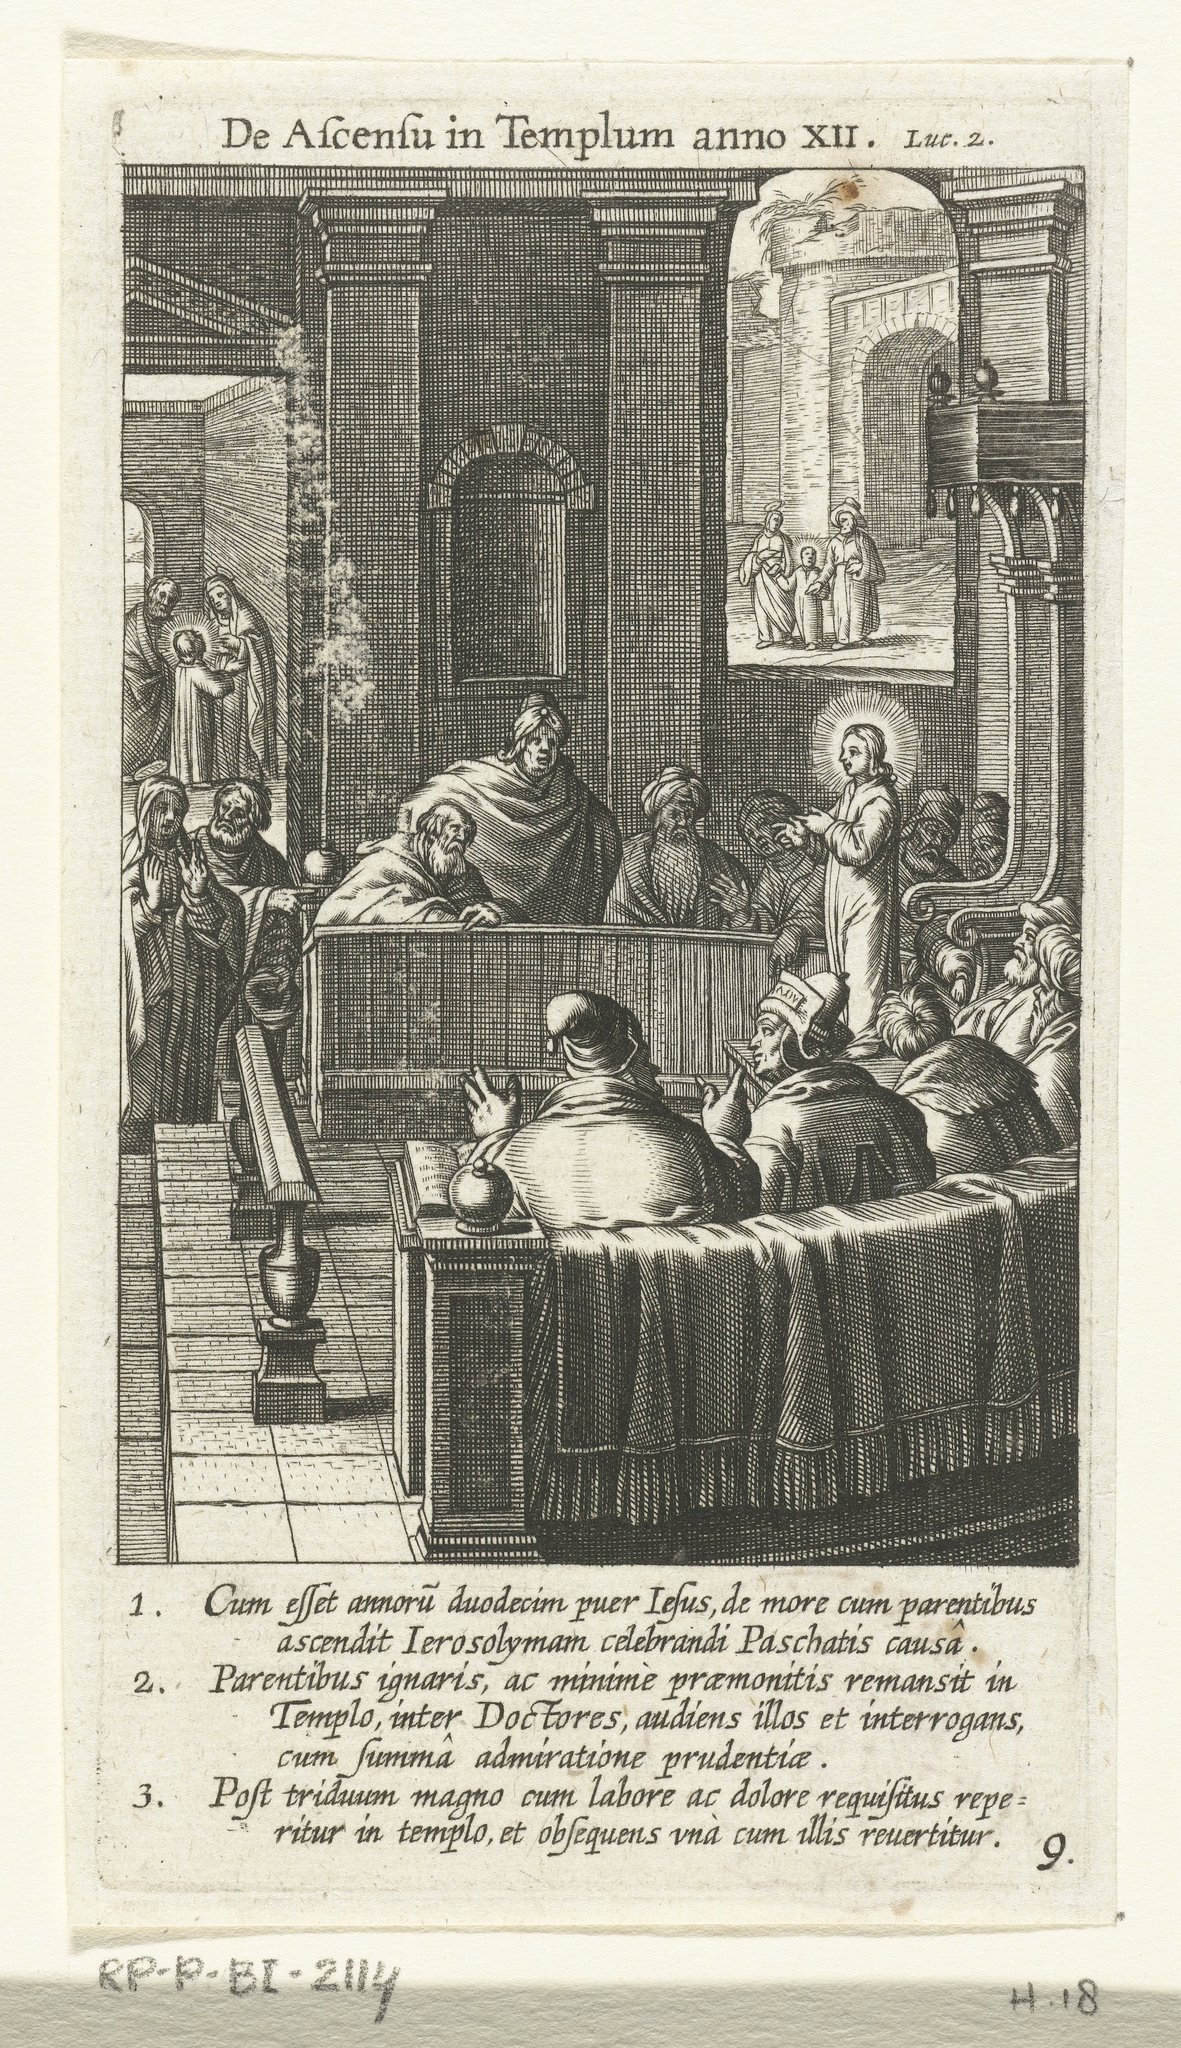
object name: book illustration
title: De Ascensu in Templum anno XII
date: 1590-1622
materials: paper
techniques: engraving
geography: antwerp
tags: christ's dispute with the doctors in the temple; he counts his arguments on his fingers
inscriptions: collector's mark: Lugt 240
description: Prent uit: Joannes Bourgois, Vitae passionis et mortis Jesu Christi Somini nostri mysteria, Antwerpen Hendrick Aertssens, 1622, afb. 9